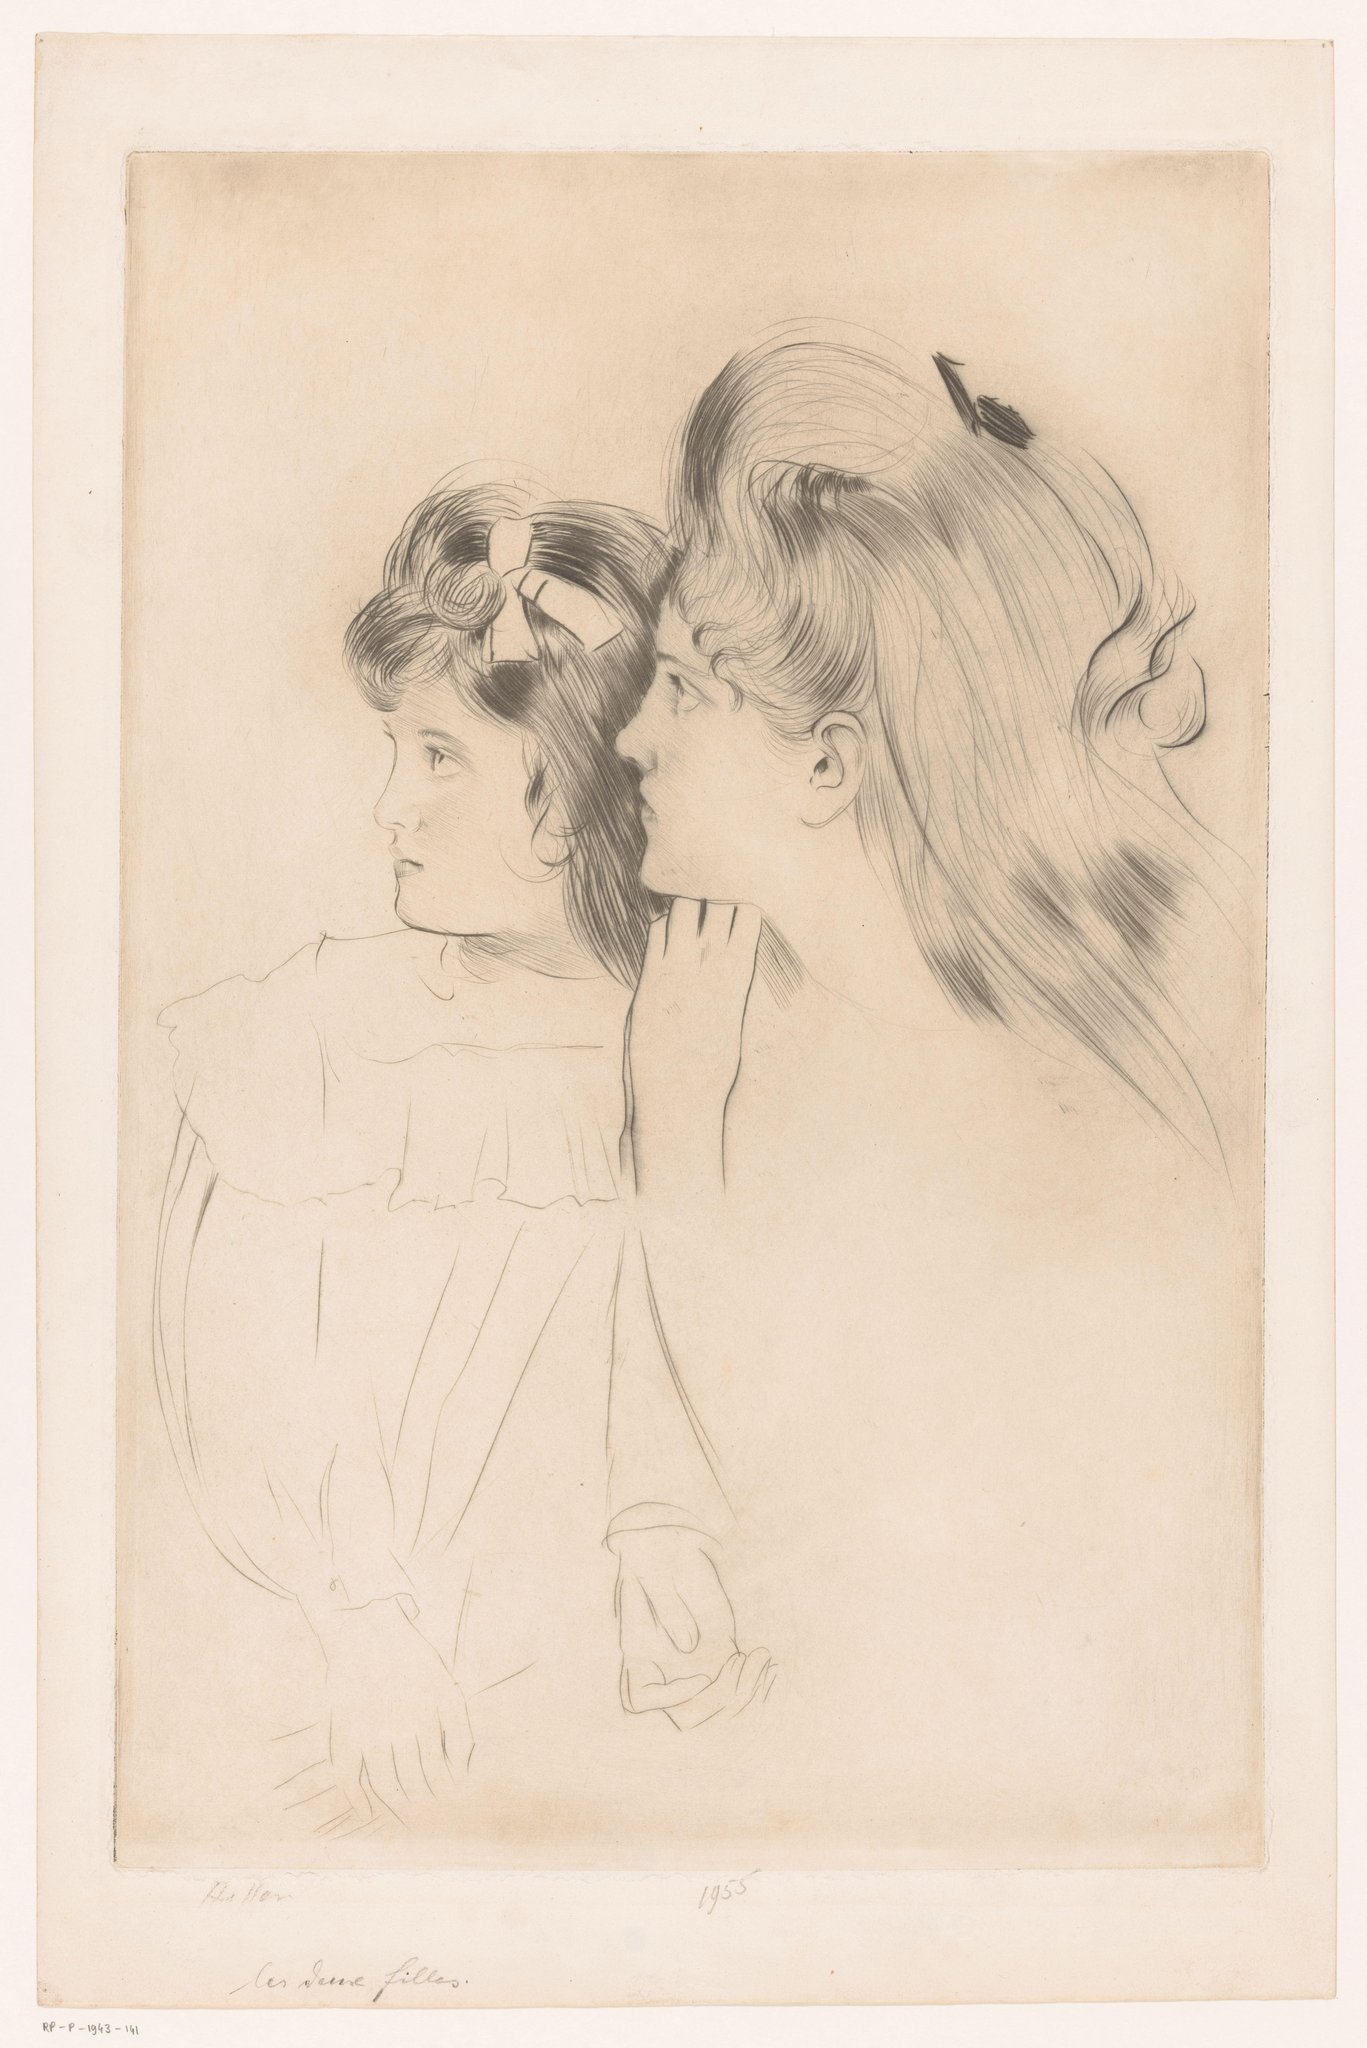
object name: print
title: Les deux filles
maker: paul césar helleu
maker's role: draughtsman, painter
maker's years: 1859-1927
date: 1869-1927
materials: paper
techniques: drypoint, intaglio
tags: adolescent, young woman, maiden, historical persons (portraits and scenes from the life)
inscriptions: collector's mark: Lugt 2228, collector's mark: Lugt 2760